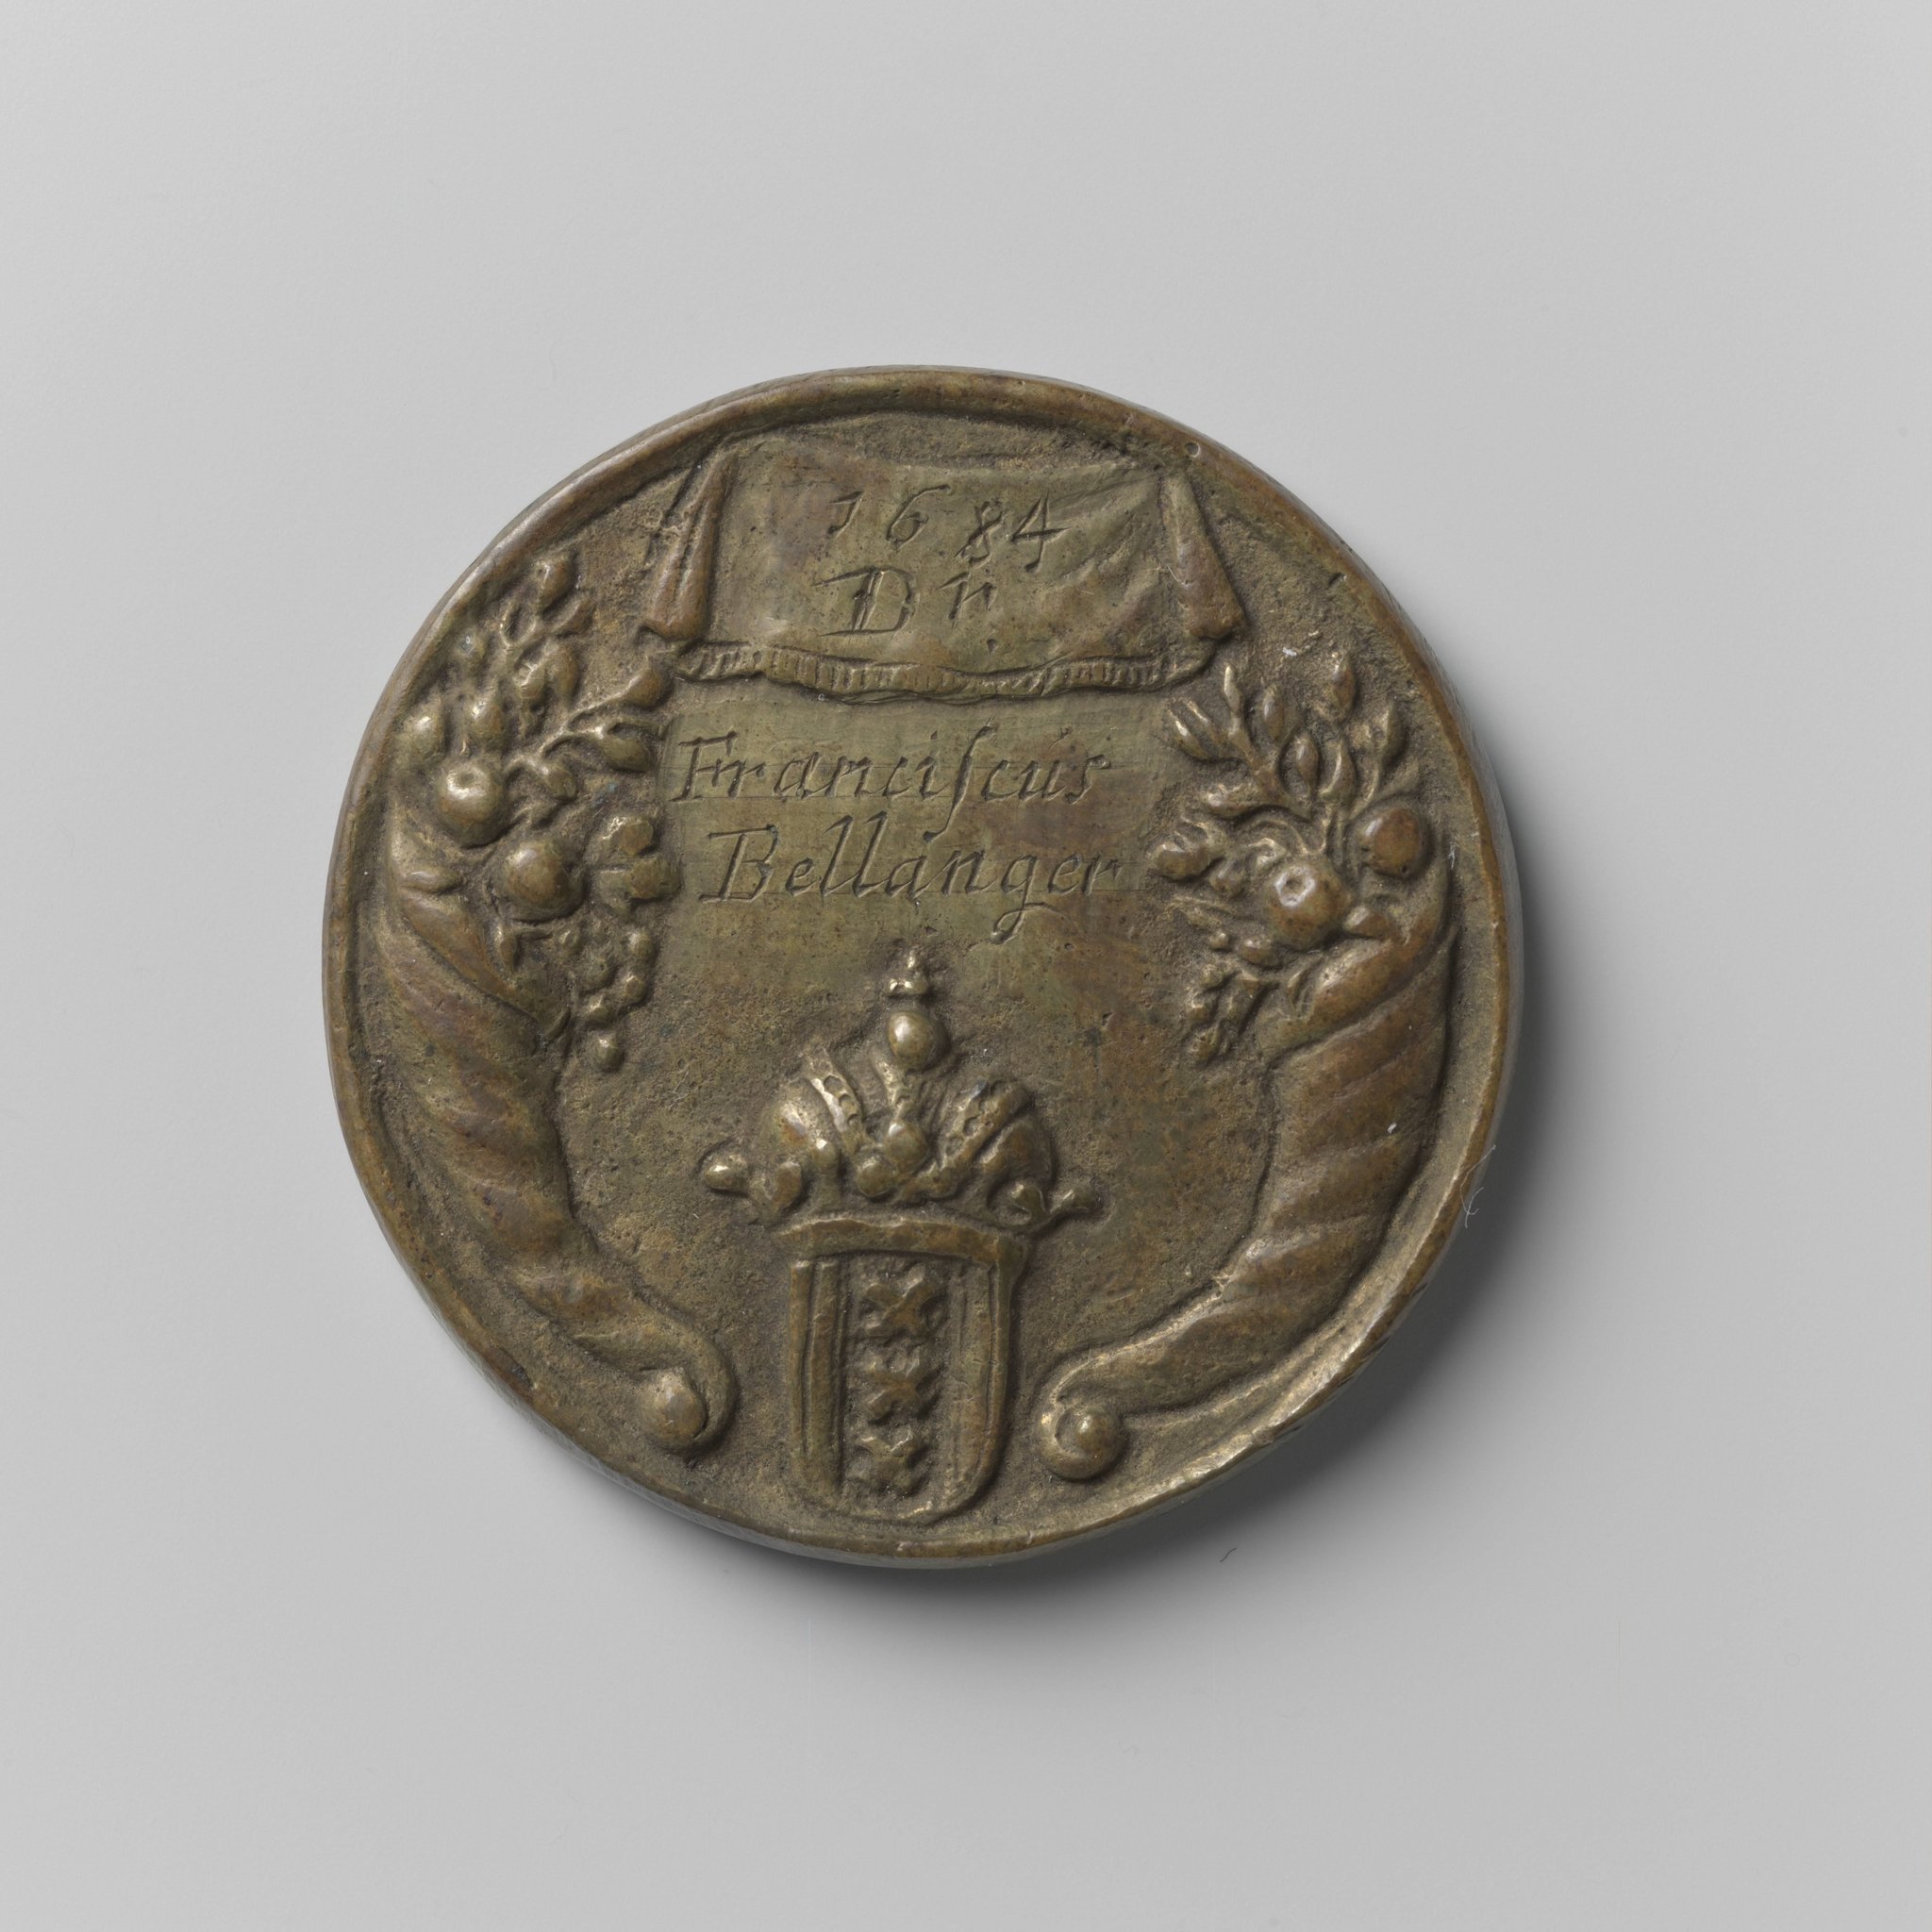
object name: toegangspenning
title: Collegium Medicum te Amsterdam, toegangspenning voor de hortus medicus voor Franciscus Bellanger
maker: aernout naghtegael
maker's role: print maker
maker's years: 1658-1745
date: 1684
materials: brass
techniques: casting, engraving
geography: amsterdam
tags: amsterdam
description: Messing penning. Voorzijde: hand uit wolken houdt tak en zalfspatel vast, waarom slang zich kronkelt binnen omschrift. Keerzijde: gekroond wapenschild tussen twee gevulde hoorns van overvloed; daartussen:opschrift onder doek met opschrift